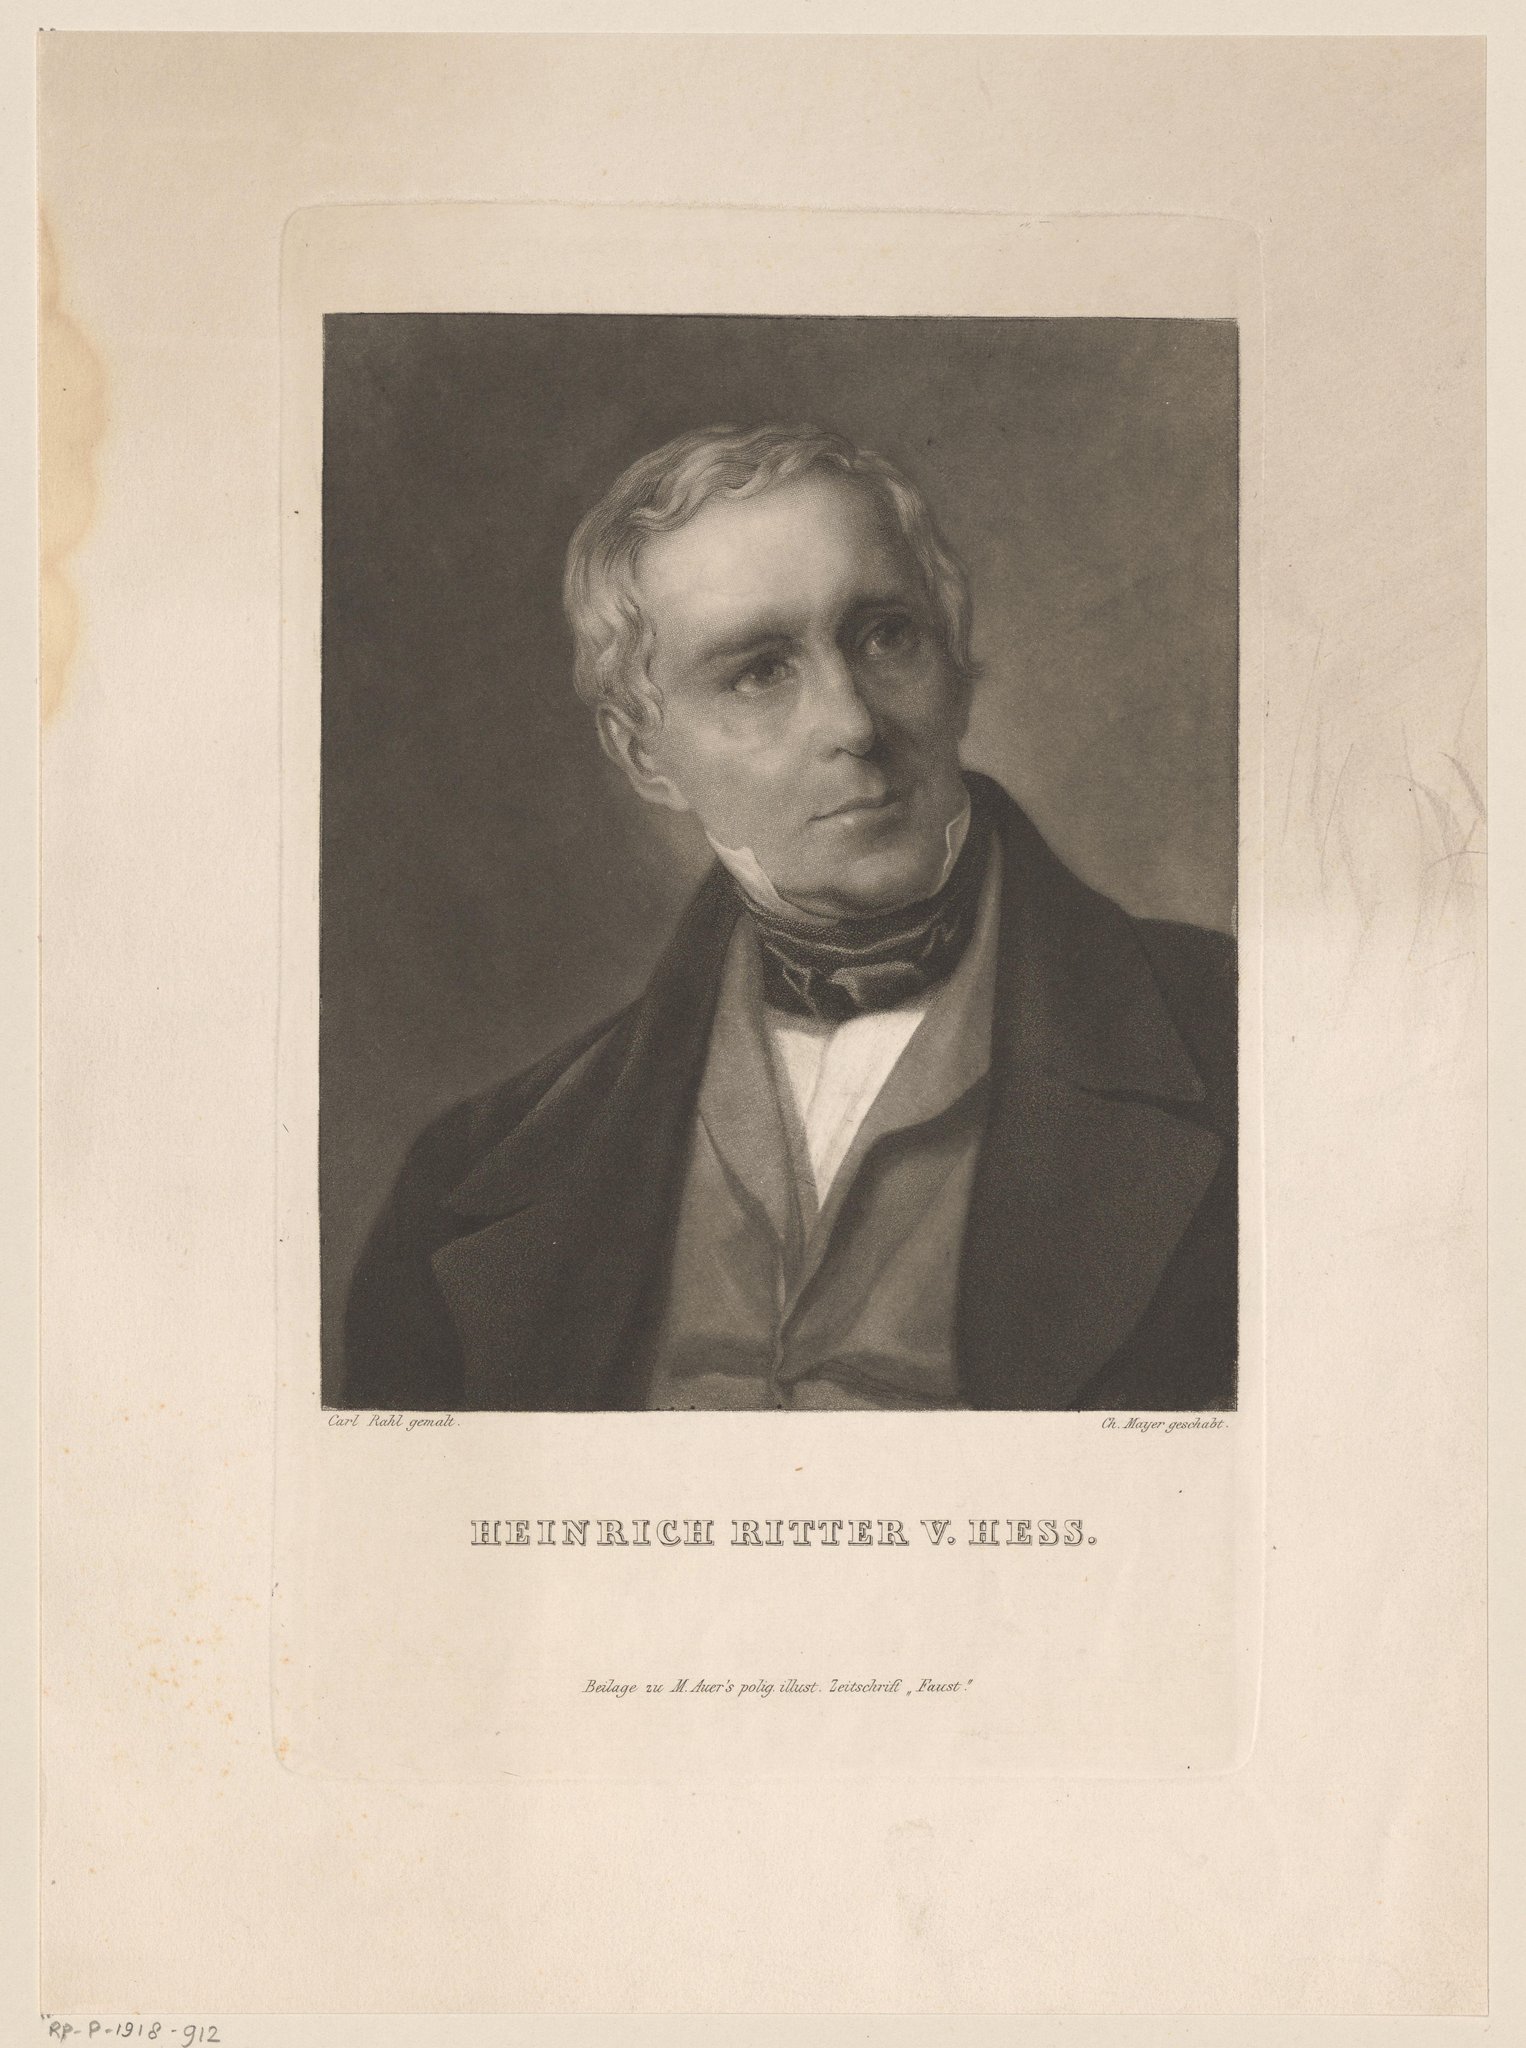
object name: print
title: Portret van Heinrich von Hess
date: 1854-1870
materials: paper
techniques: engraving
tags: vienna, commander-in-chief, general, marshal, historical persons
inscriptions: collector's mark: Lugt 2233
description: Prent gepubliceerd als bijlage van het tijdschrift: Faust. Poligrafisch illustrirte Zeitschrift für Kunst, Wissenschaft, Industrie, und geselliges Leben (...).